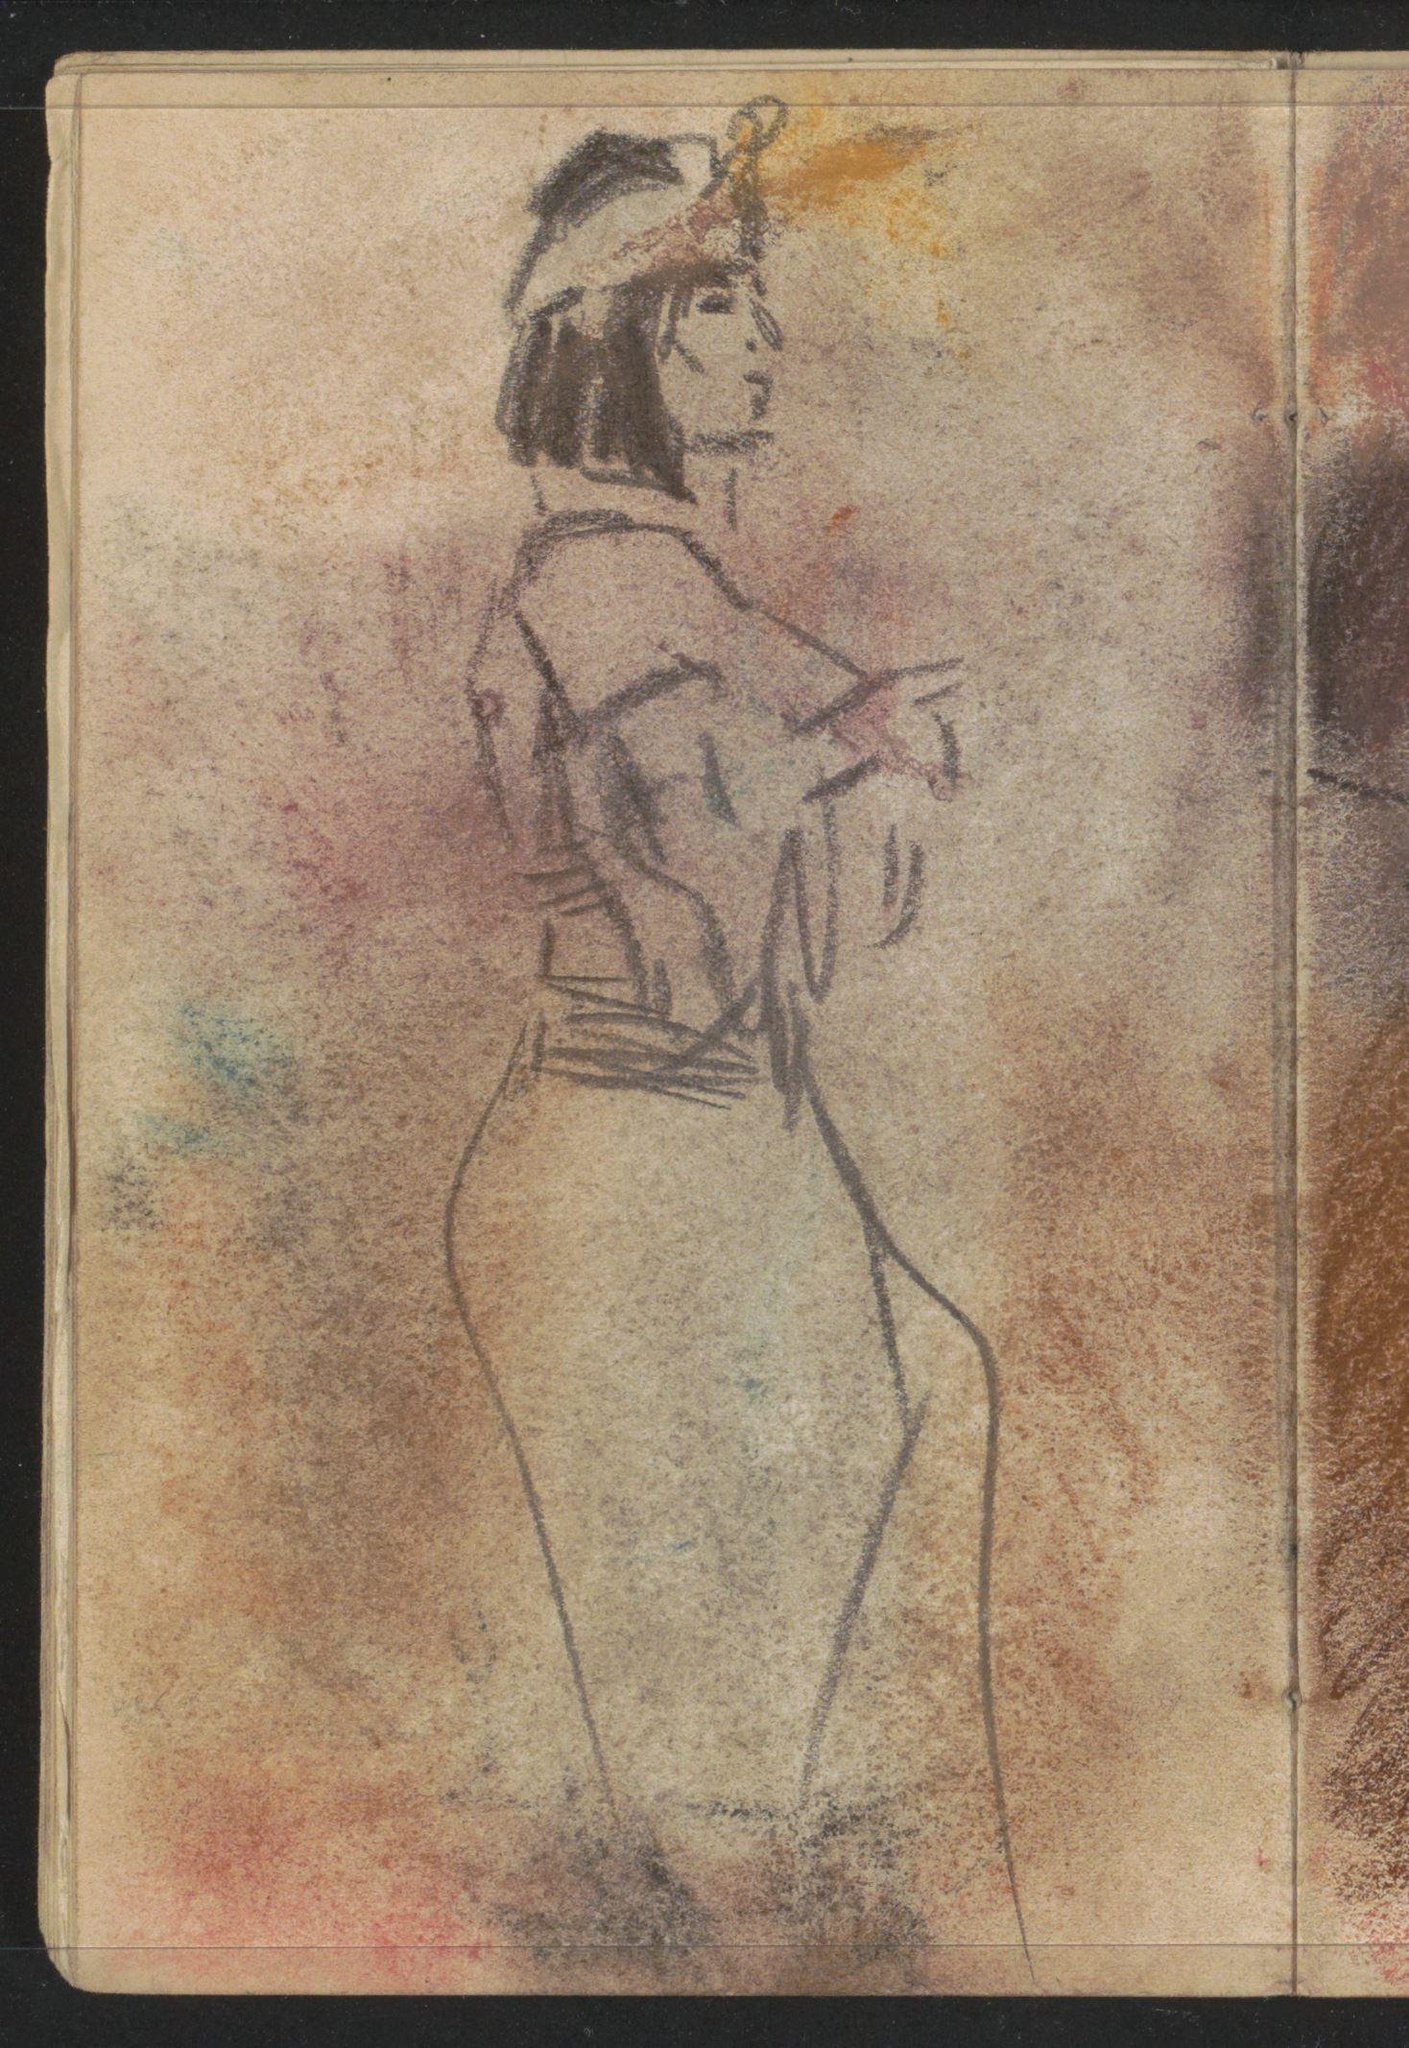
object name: sketchbook leaf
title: Staande vrouw in oosterse kleding, in profiel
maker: isaac israels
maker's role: draughtsman, painter, print maker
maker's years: 1865-1934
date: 1887-1934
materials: chalk, paper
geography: paris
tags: adult woman (+ standing)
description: Pagina 19 uit schetsboek XXXIX met 51 pagina's.